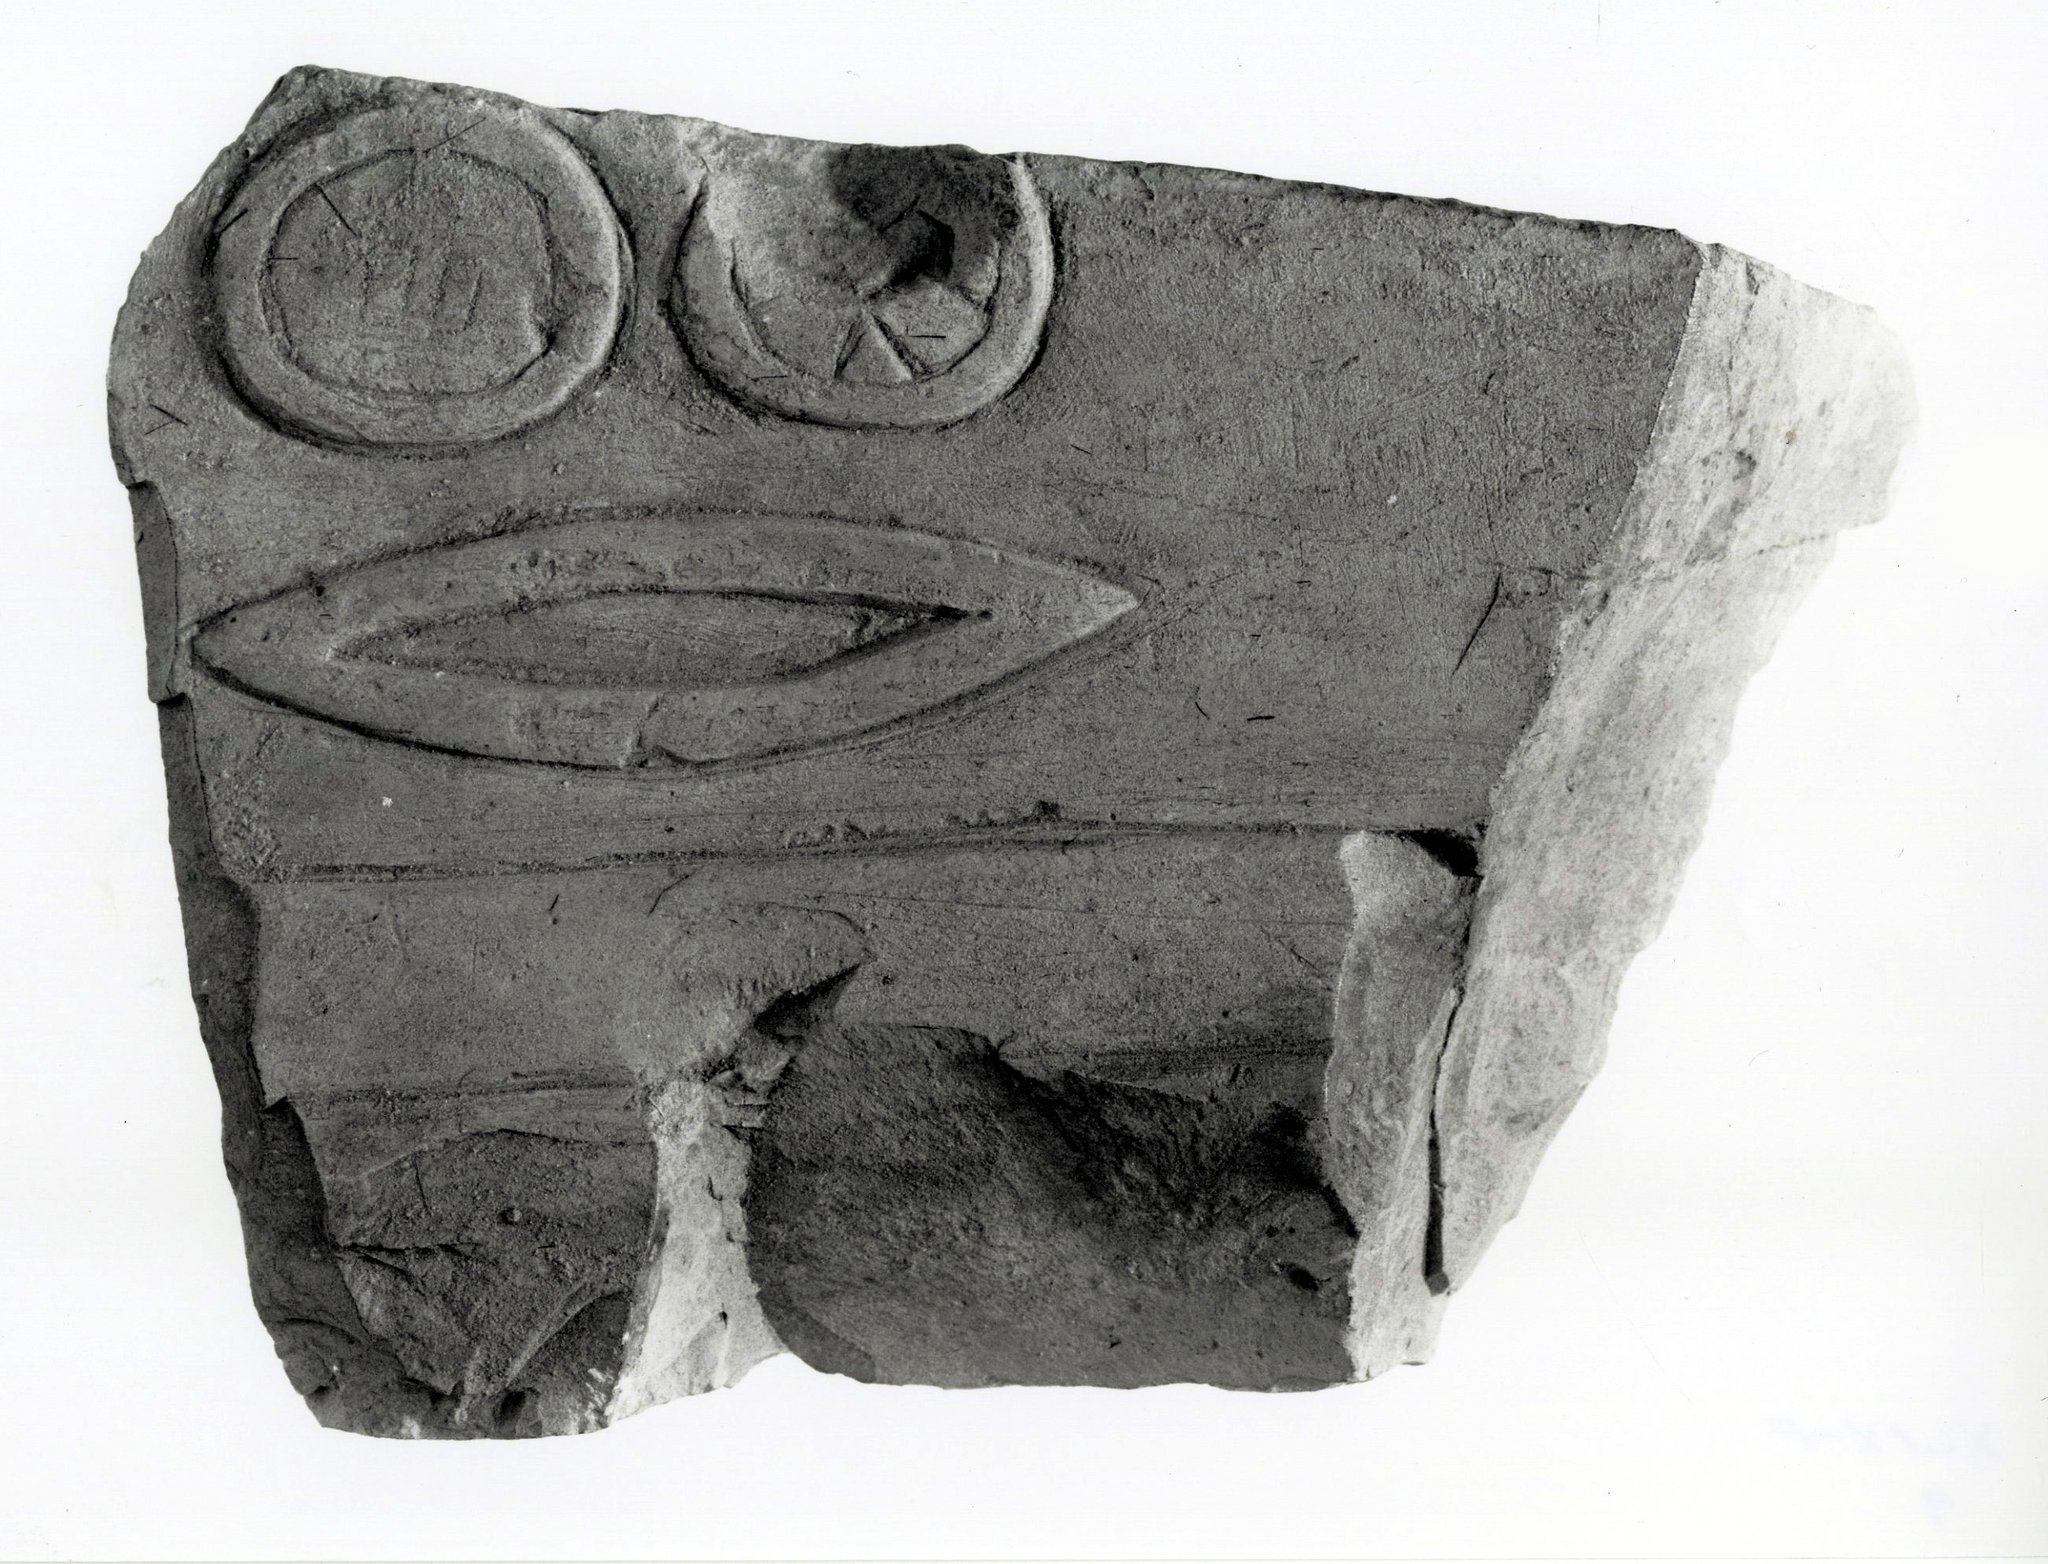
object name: relief, tomb of nespekashuty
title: Raised relief fragment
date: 664-610 BCE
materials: limestone, varnish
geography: egypt